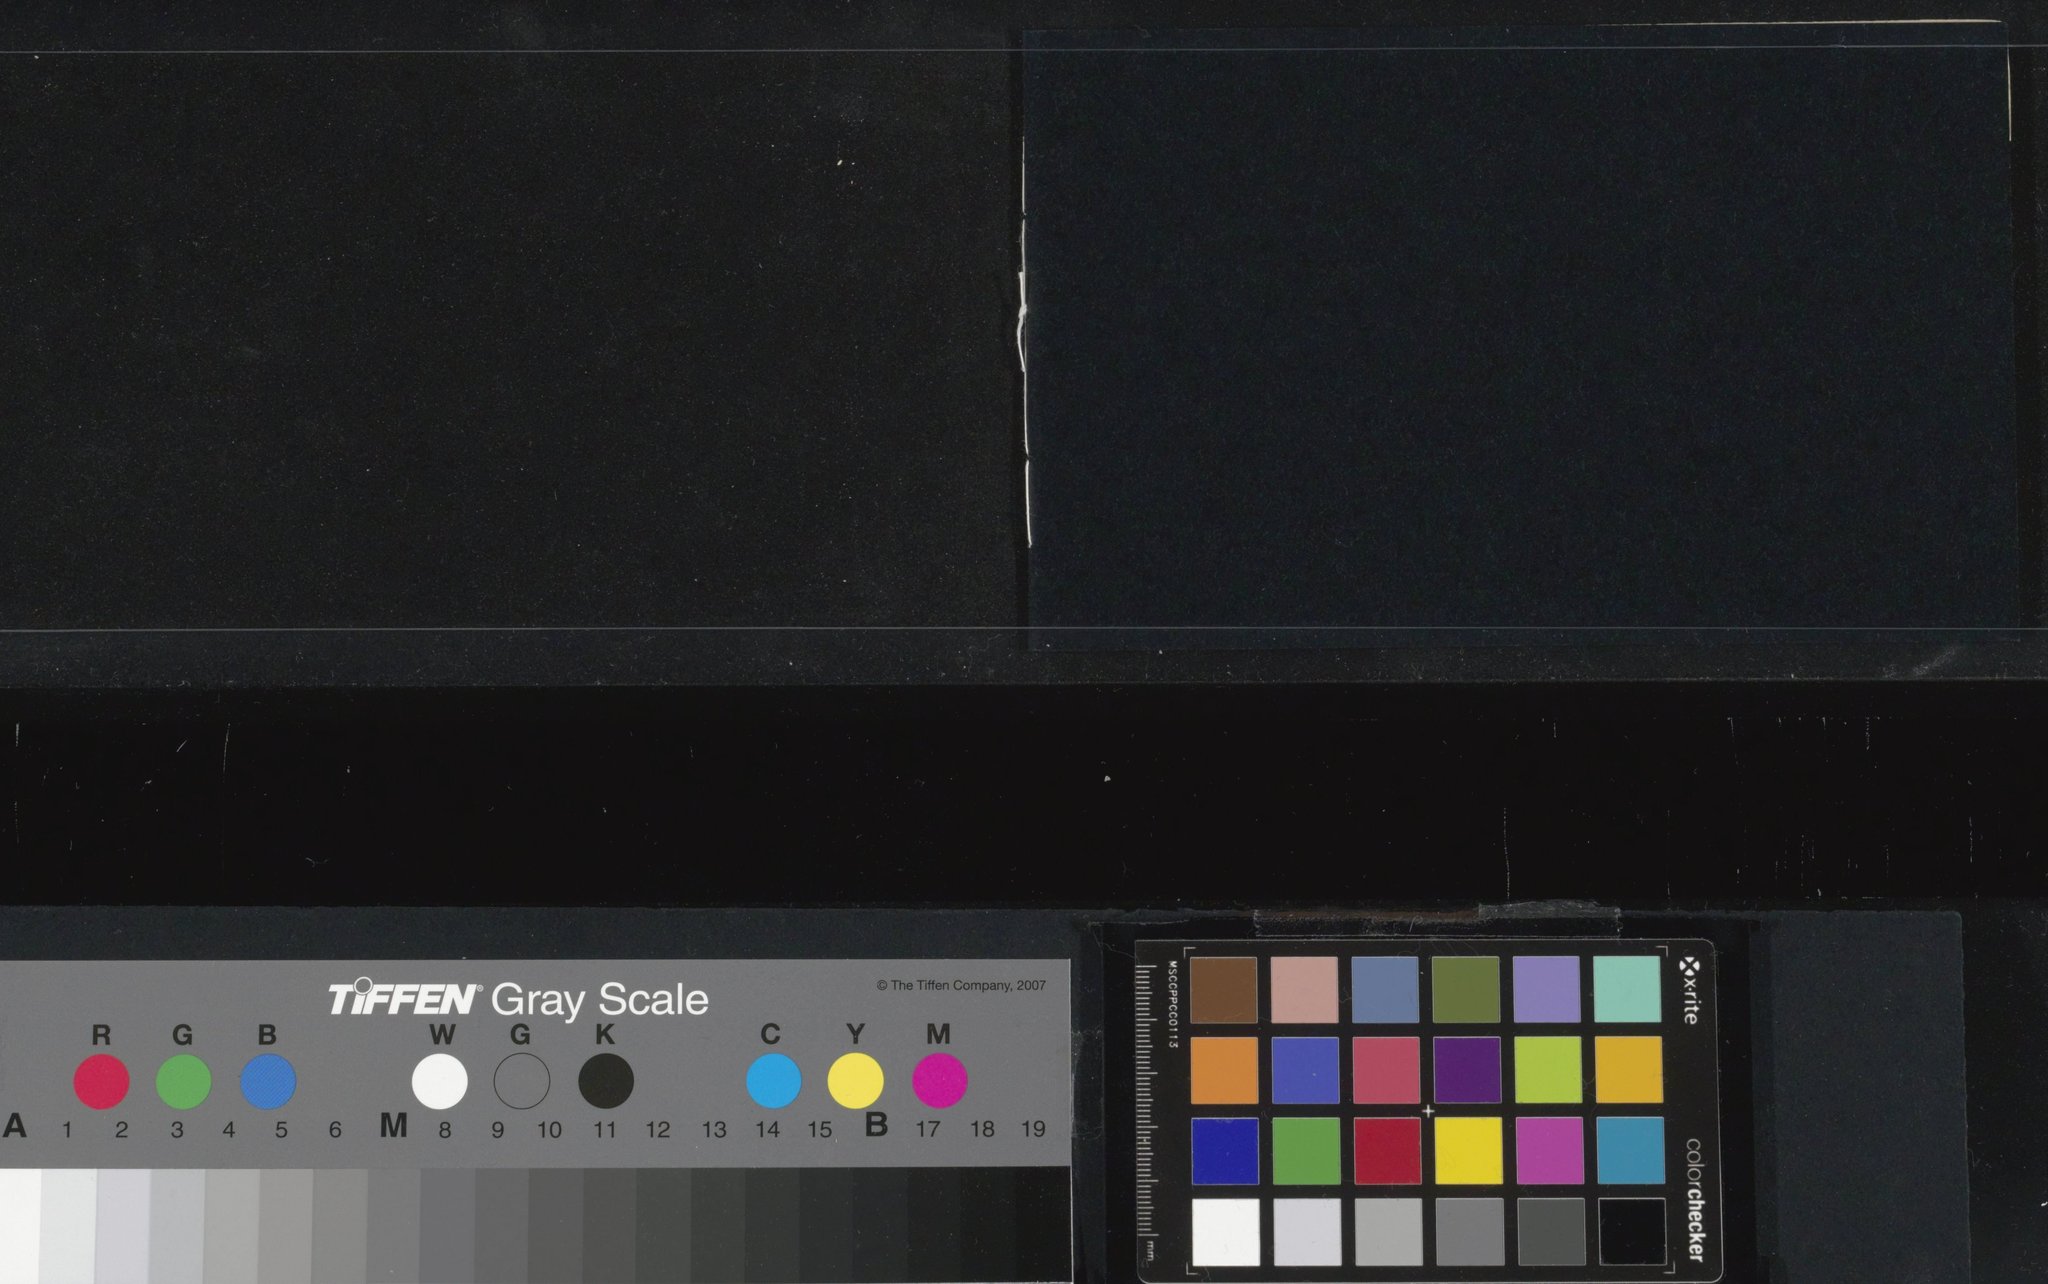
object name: sketchbook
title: Schetsboek met 8 bladen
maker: marius bauer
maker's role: draughtsman, print maker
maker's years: 1867-1932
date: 1877-1885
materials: chalk, paper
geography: scheveningen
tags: beach (as place of recreation), sea (seascape), beach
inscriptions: collector's mark: Lugt 2228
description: Schetsboek bestaande uit 8 bladen met zeegezichten, recreatie aan het strand en soldaten.